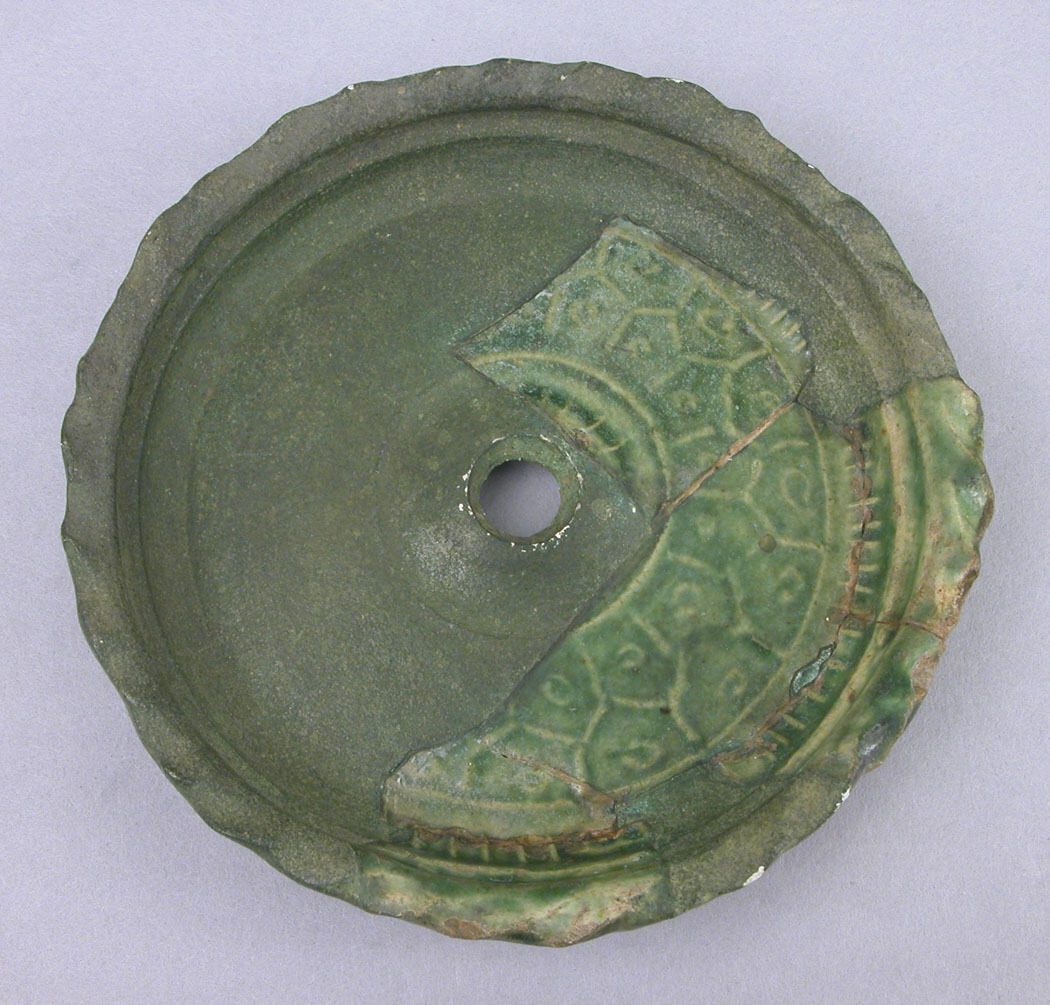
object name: ewer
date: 701-900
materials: earthenware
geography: iran